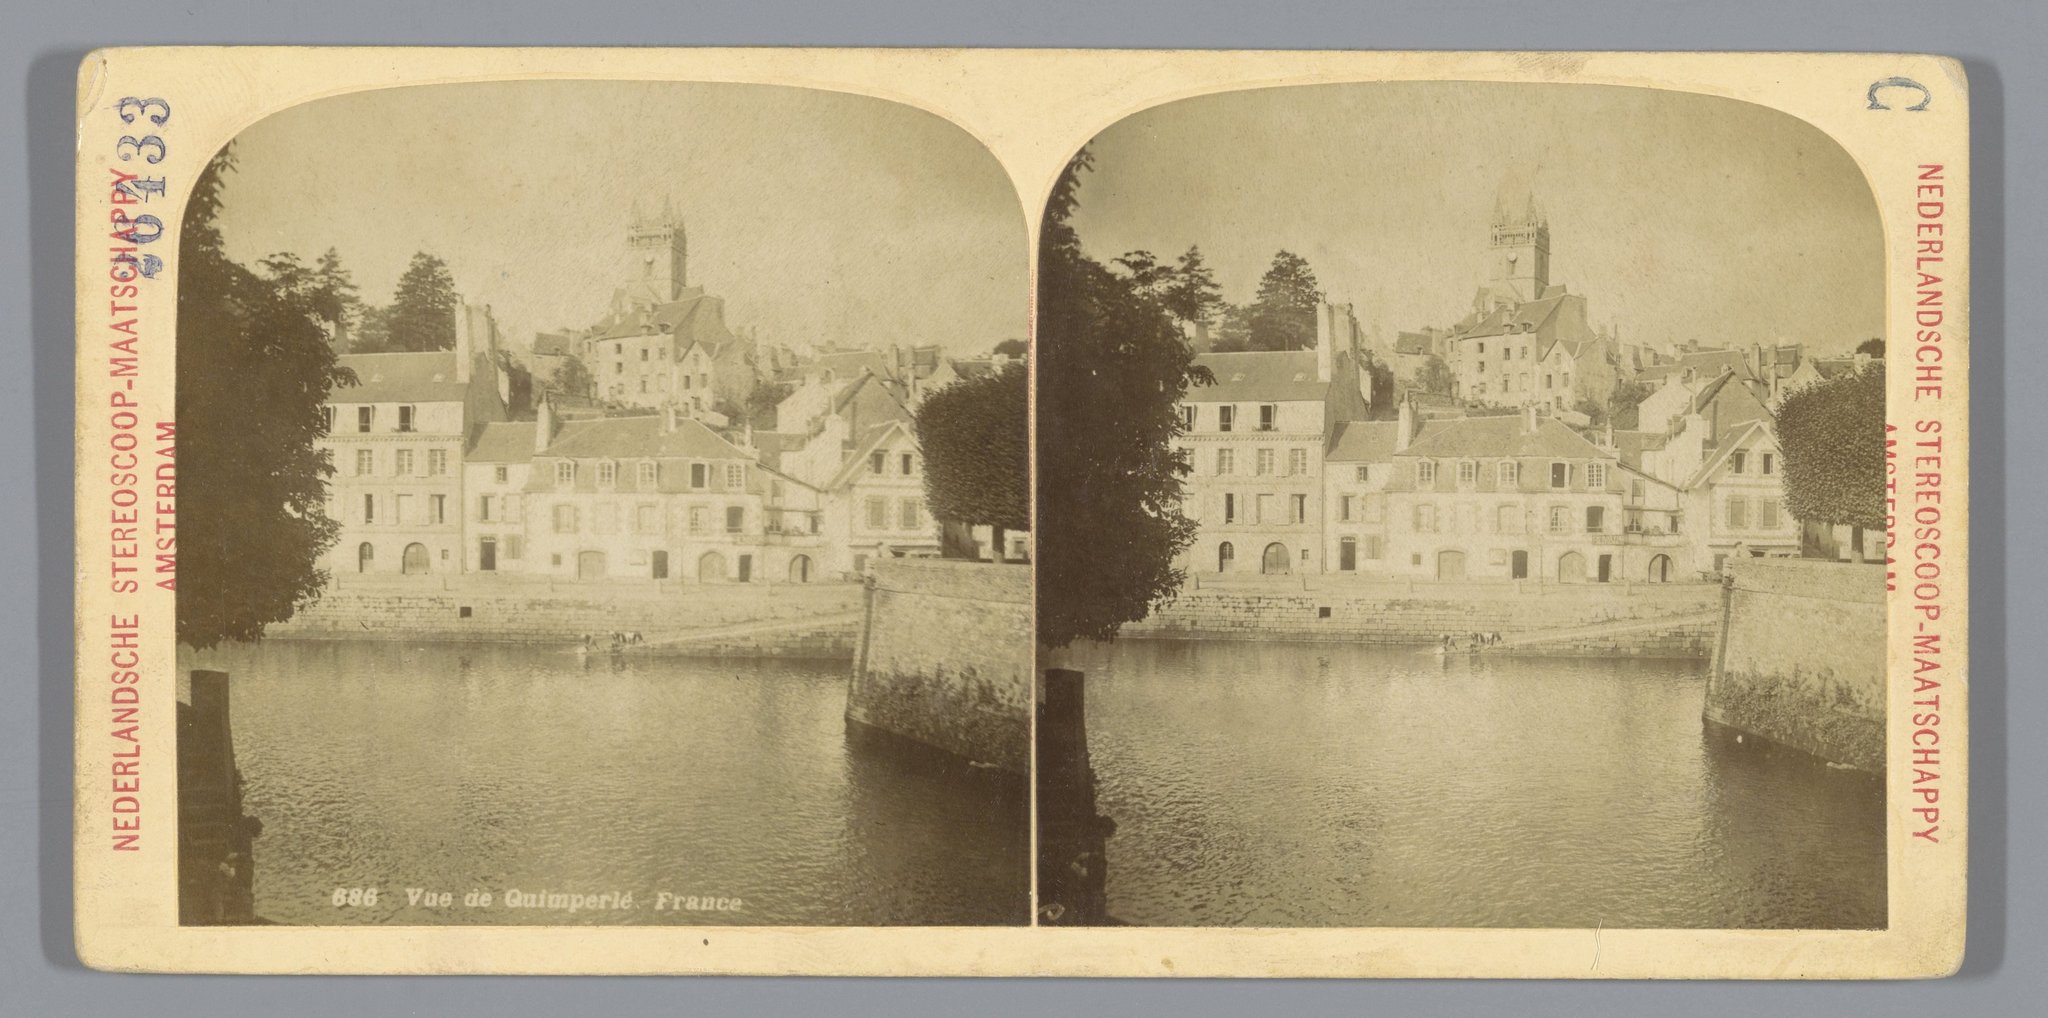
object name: stereograph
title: Gezicht op Quimperlé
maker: j.g. beers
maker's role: fotograaf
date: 1850-1880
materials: cardboard, photographic support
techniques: albumen print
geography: amsterdam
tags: city-view, and landscape with man-made constructions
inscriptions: number: ‘26433 C’, number: ‘686’